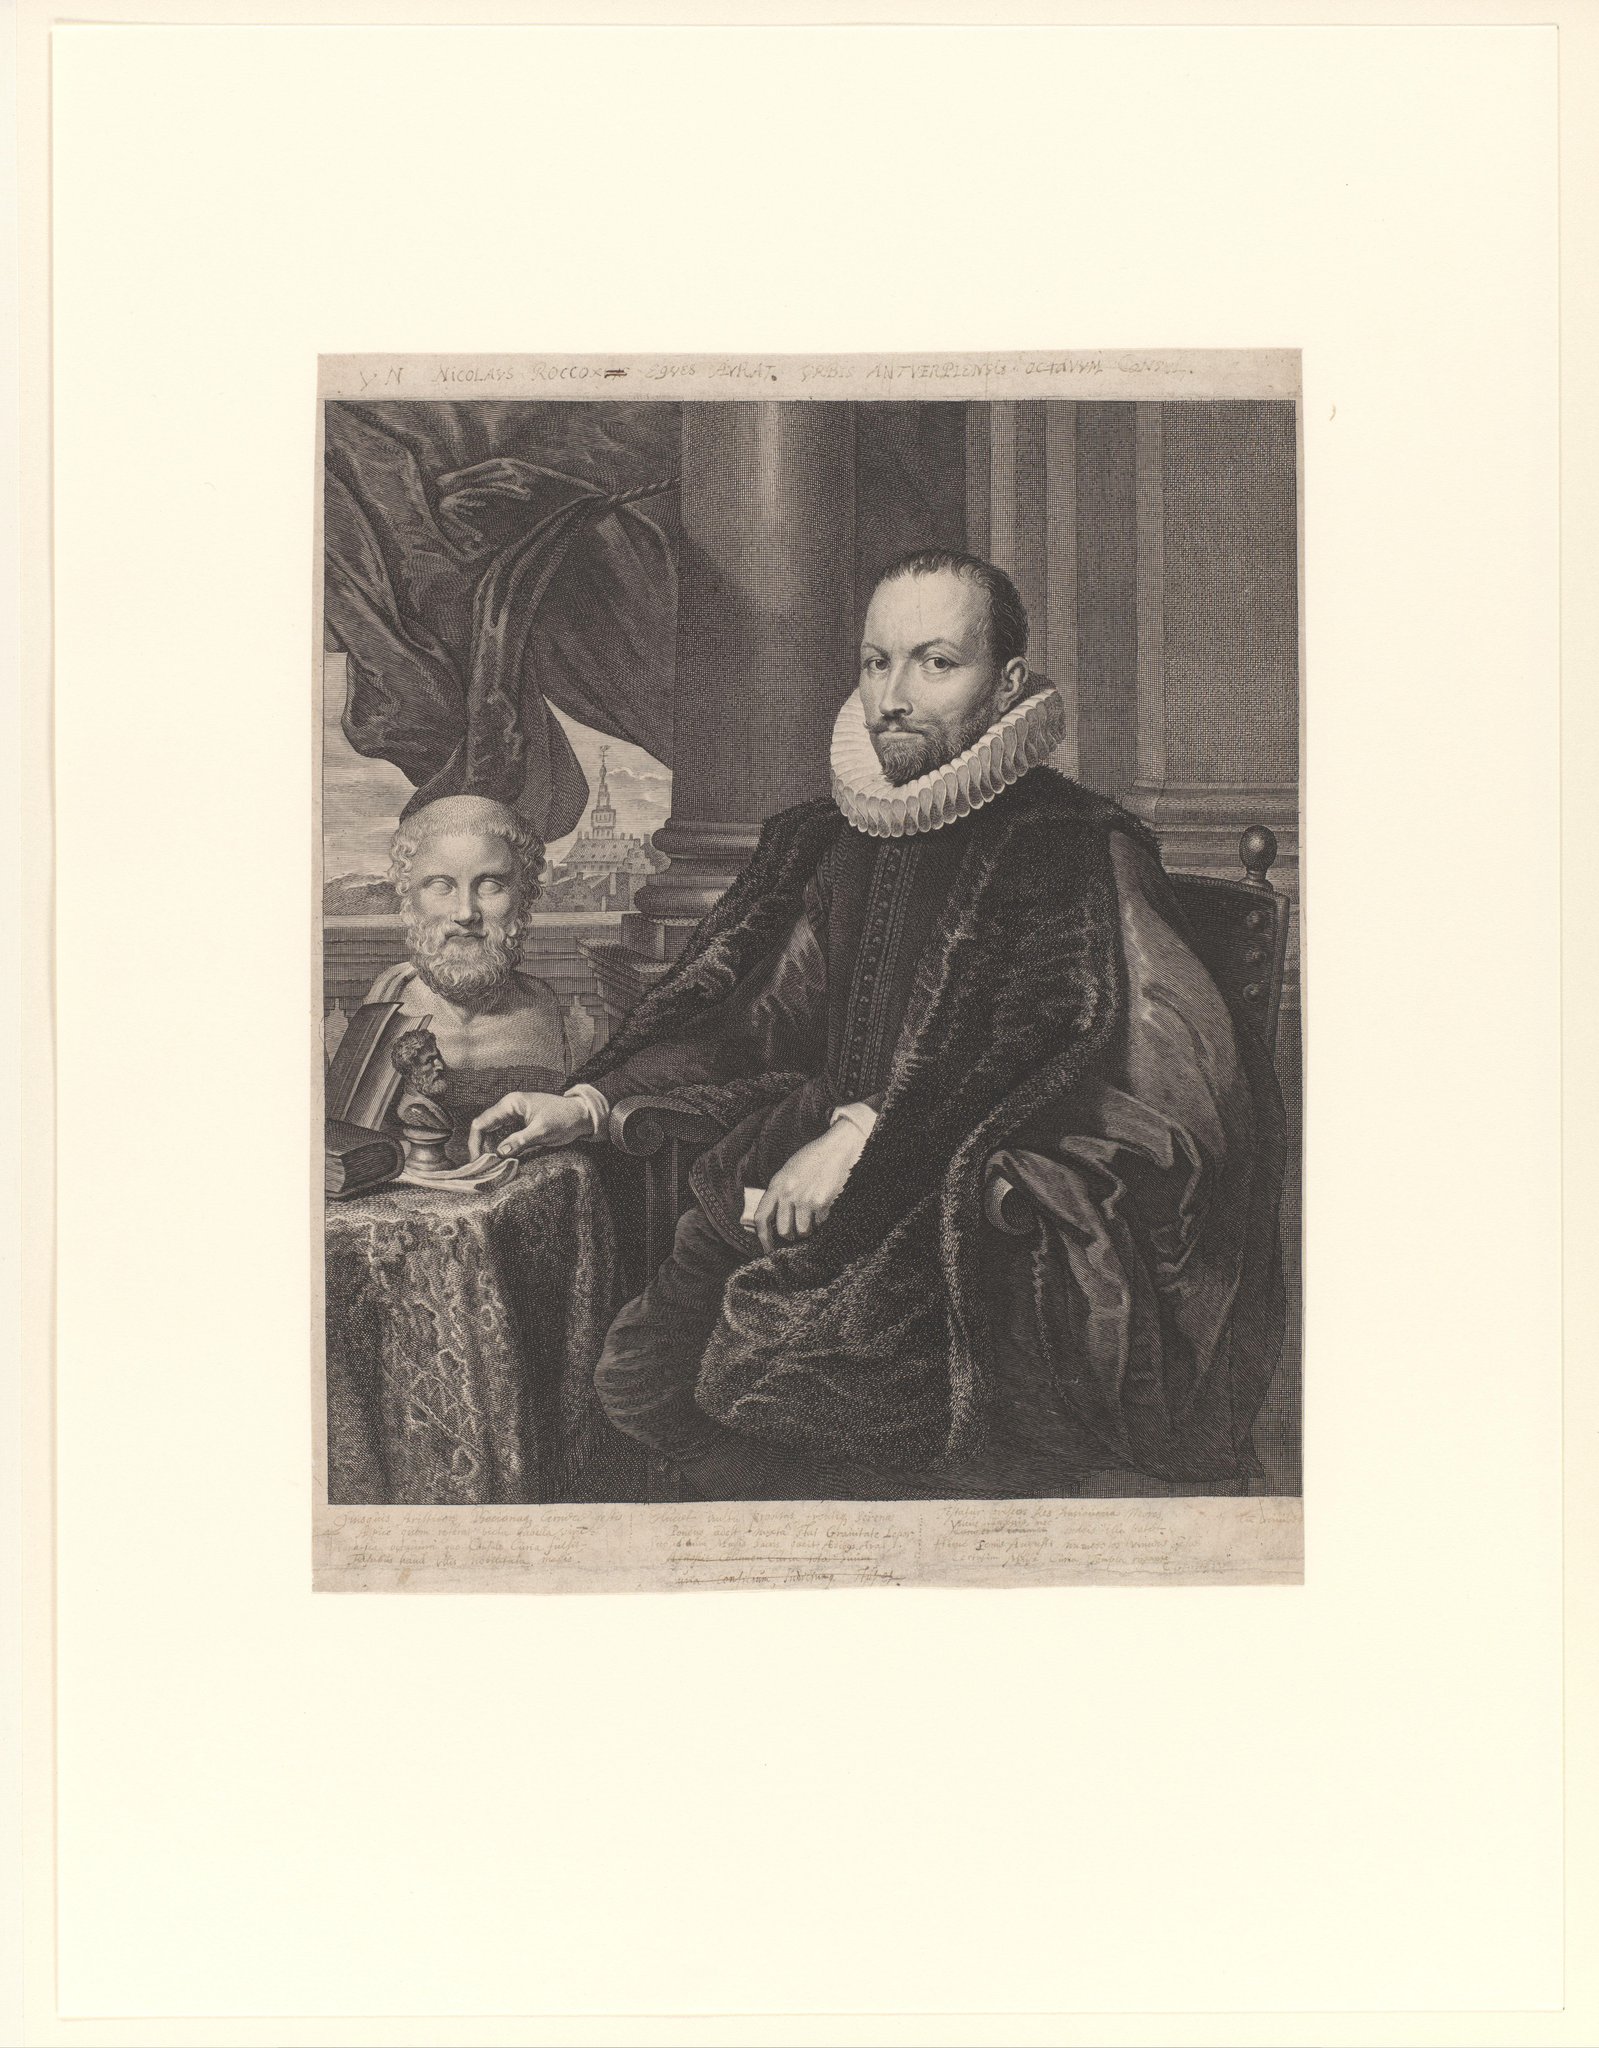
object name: print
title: Portret van Nikolaas Rockox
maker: lucas vorsterman (i)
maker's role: print maker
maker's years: 1595-1675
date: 1625-1666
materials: paper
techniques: engraving, pen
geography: antwerp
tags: antwerp, mayor, nikolaas rockox, (story of) demosthenes - portrait of person from classical history (+ full face)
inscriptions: collector's mark: Lugt 240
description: Portret van Nikolaas Rockox, burgemeester van Antwerpen en kunstliefhebber. Hij zit in een interieur met voor hem op tafel boeken en kunstvoorwerpen, waaronder een buste van de Griekse redenaar en politicus Demosthenes.